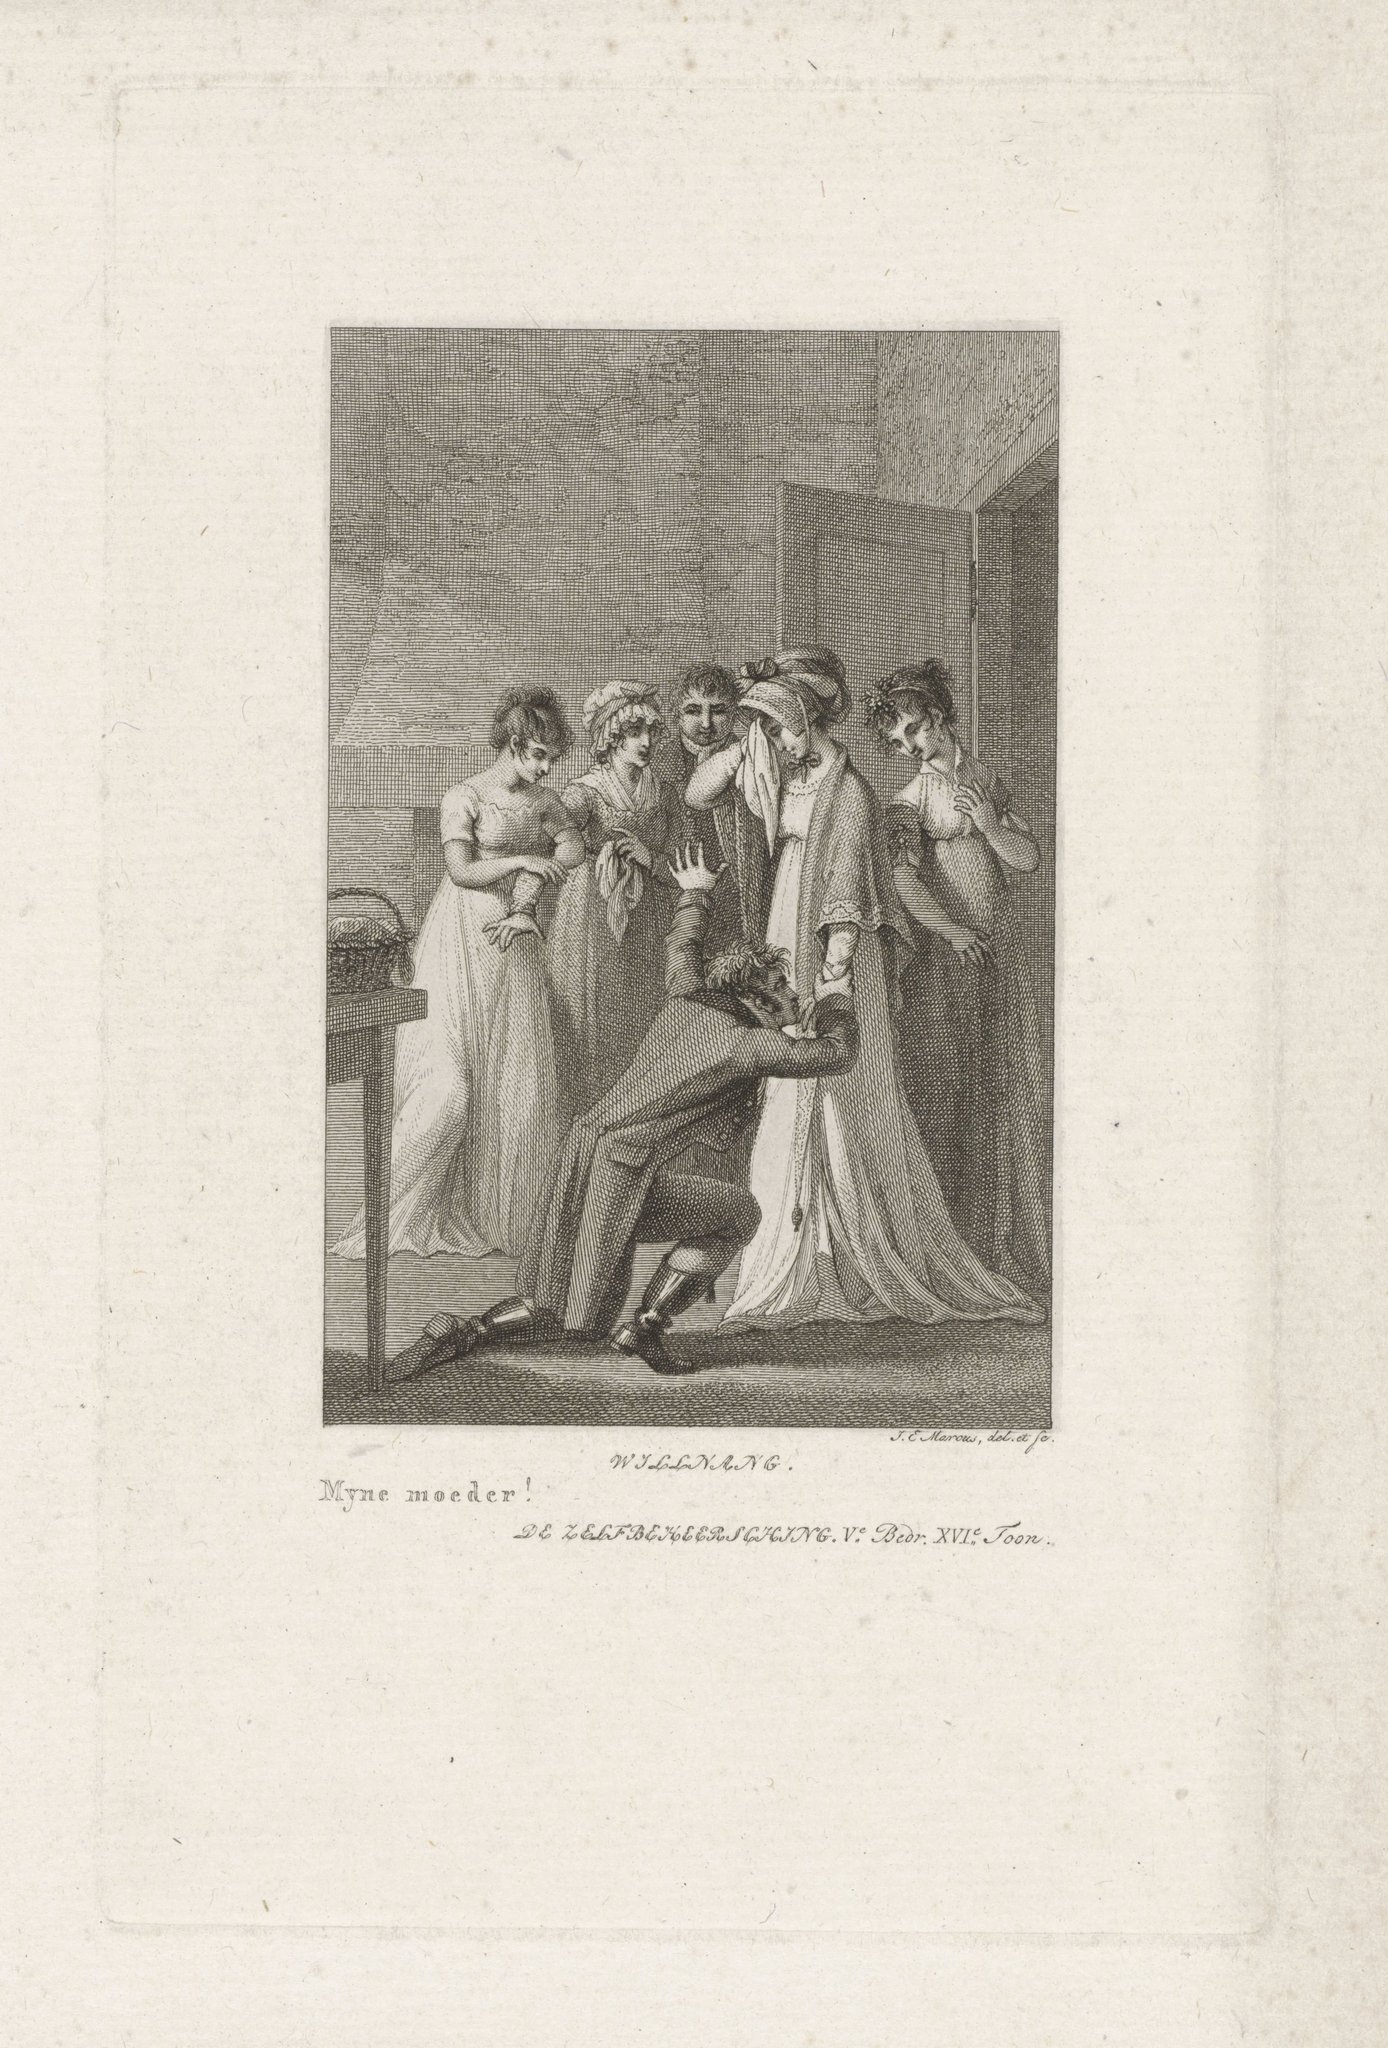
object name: print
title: Willnang/ Myne moeder!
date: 1804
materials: paper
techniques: etching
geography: amsterdam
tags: kissing the hand (lovers) (+ variant), weeping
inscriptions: collector's mark: Lugt 2233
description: In een interieur bij een deuropening knielt een man bij een geëmotioneerde vrouw en geeft haar een handkus. In de kamer staan nog drie vrouwen en een man. Scèene uit het toneelstuk: De zelfbeheersching van August Wilhelm Iffland. Rechtsonder gemerkt: Ve. Bedr. XVIe Toon.